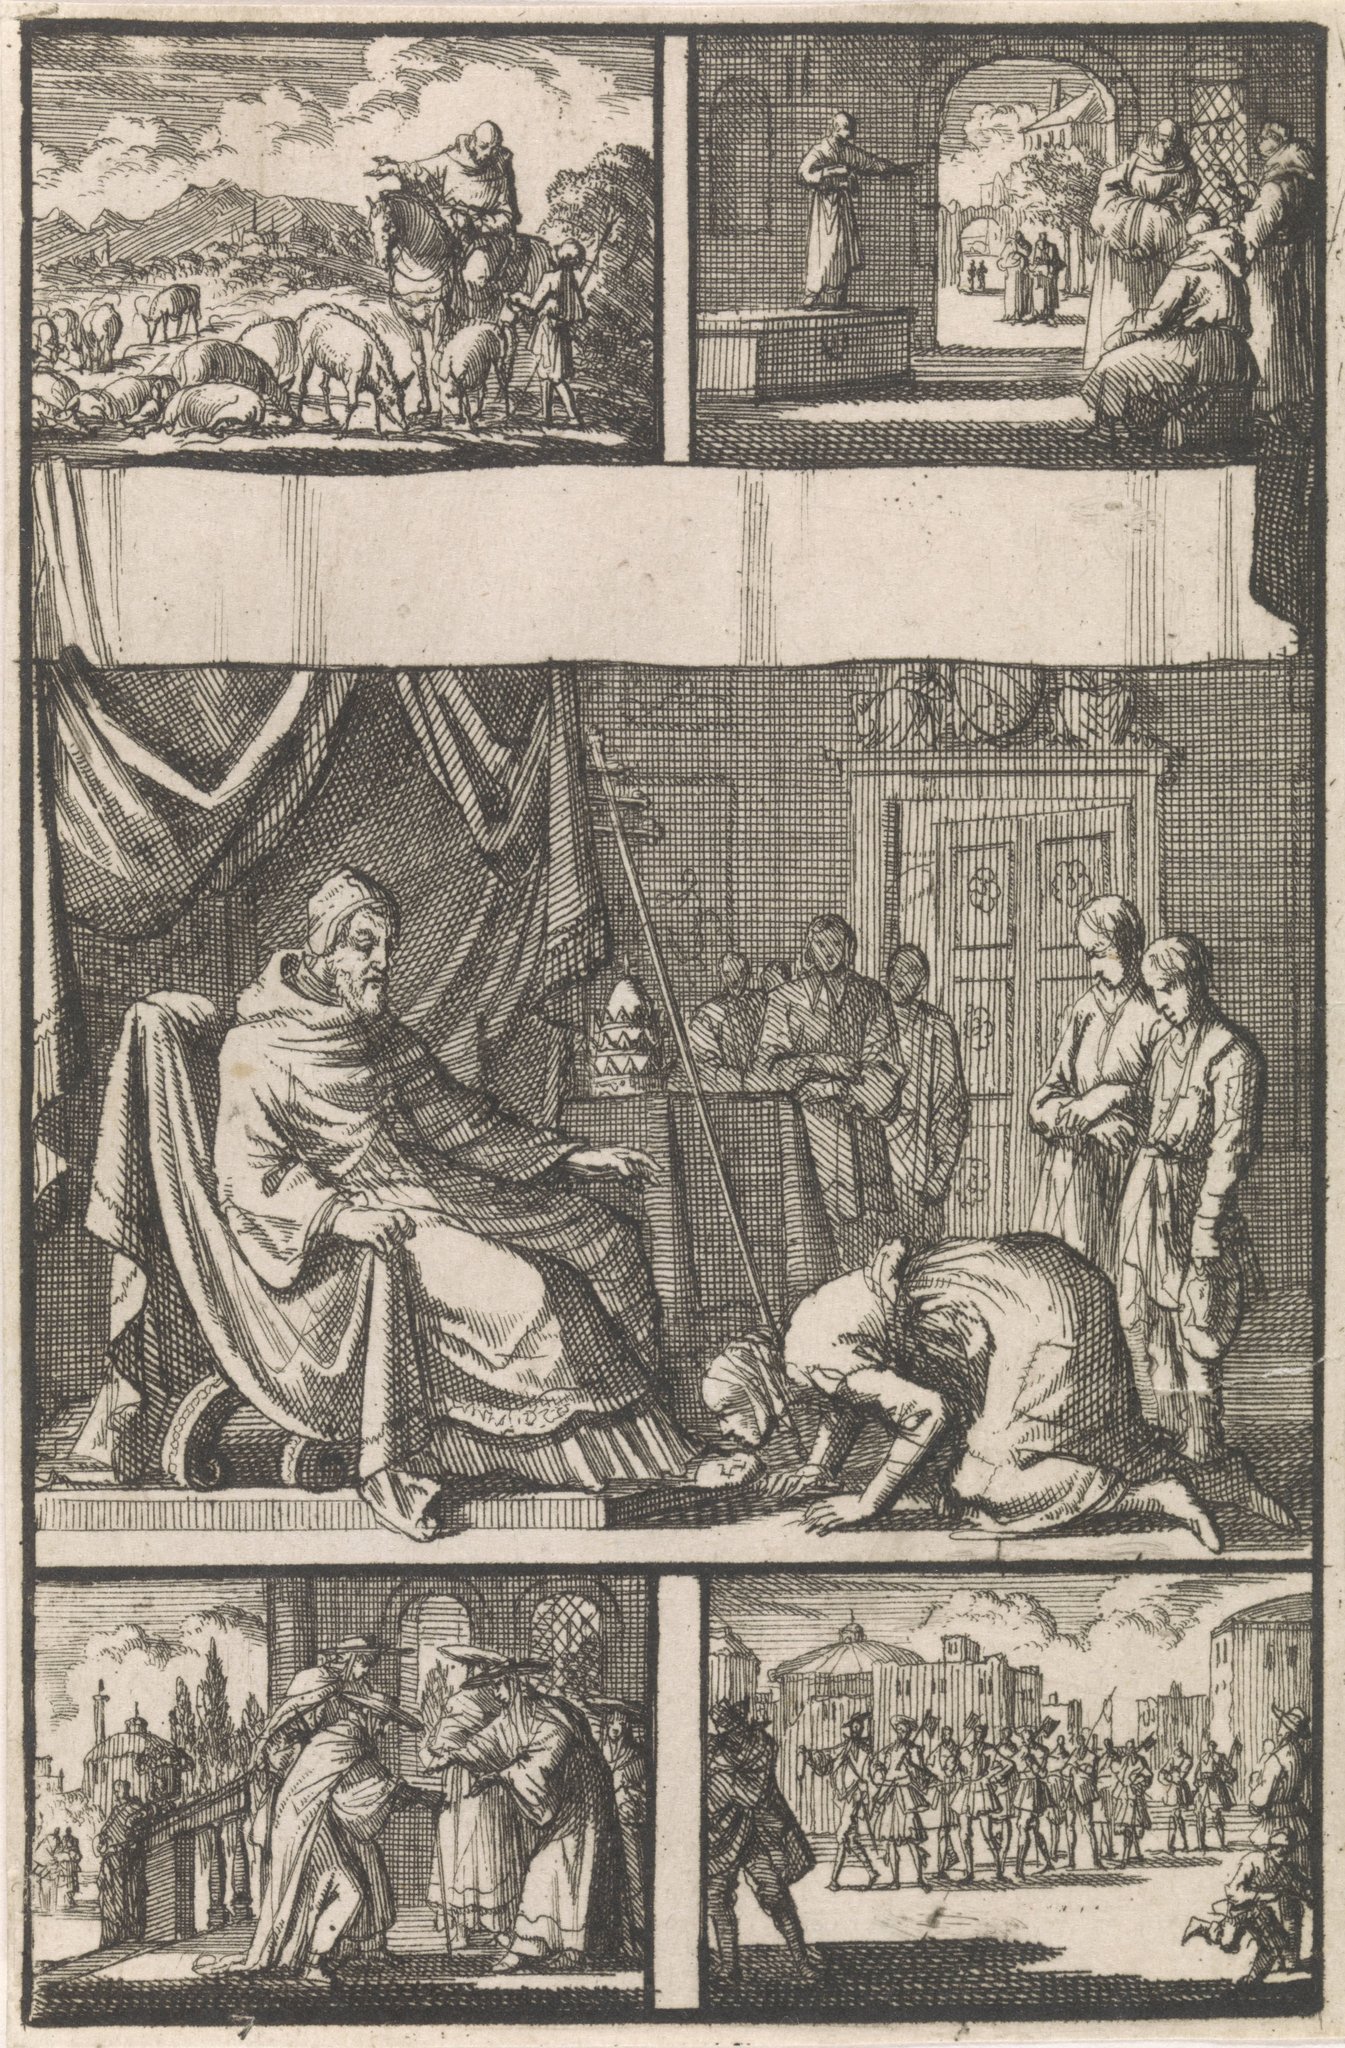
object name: print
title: Camilla, de zuster van paus Sixtus V, kust geknield zijn voet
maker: jan luyken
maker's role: draughtsman, print maker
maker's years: 1649-1712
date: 1697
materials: paper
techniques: etching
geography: amsterdam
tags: sixtus v, kissing the pope's feet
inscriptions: collector's mark: Lugt 2228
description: Proefdruk van titelpagina voor: Leti, Gregorio. Het leeven van Sixtus den Vyfden, paus van Rome, 2 delen. Gillis en Johannes Janssonius van Waesberge en wed. Steven Swart, 1697, dl. I.